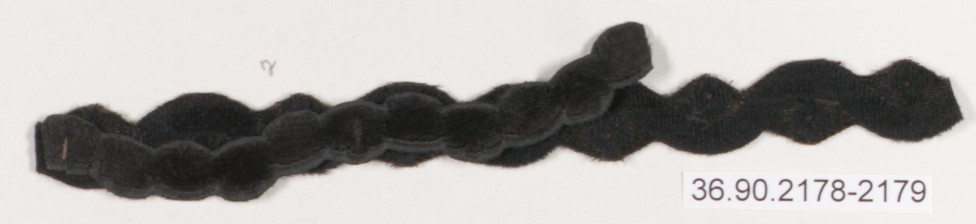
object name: piece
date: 1801-1900